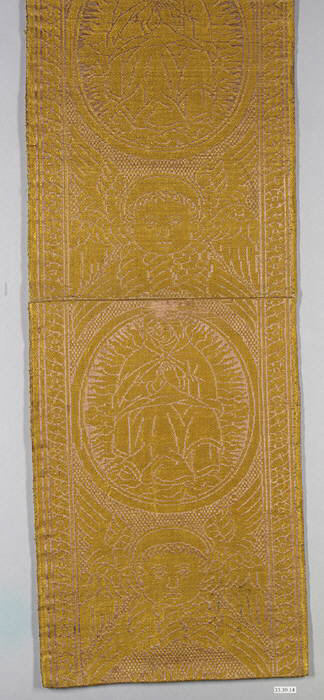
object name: orphrey fragment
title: Orphrey woven with figurative repeat design of Seraphim and the Virgin and Child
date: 1401-1600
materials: linen, silk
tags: angels,jesus